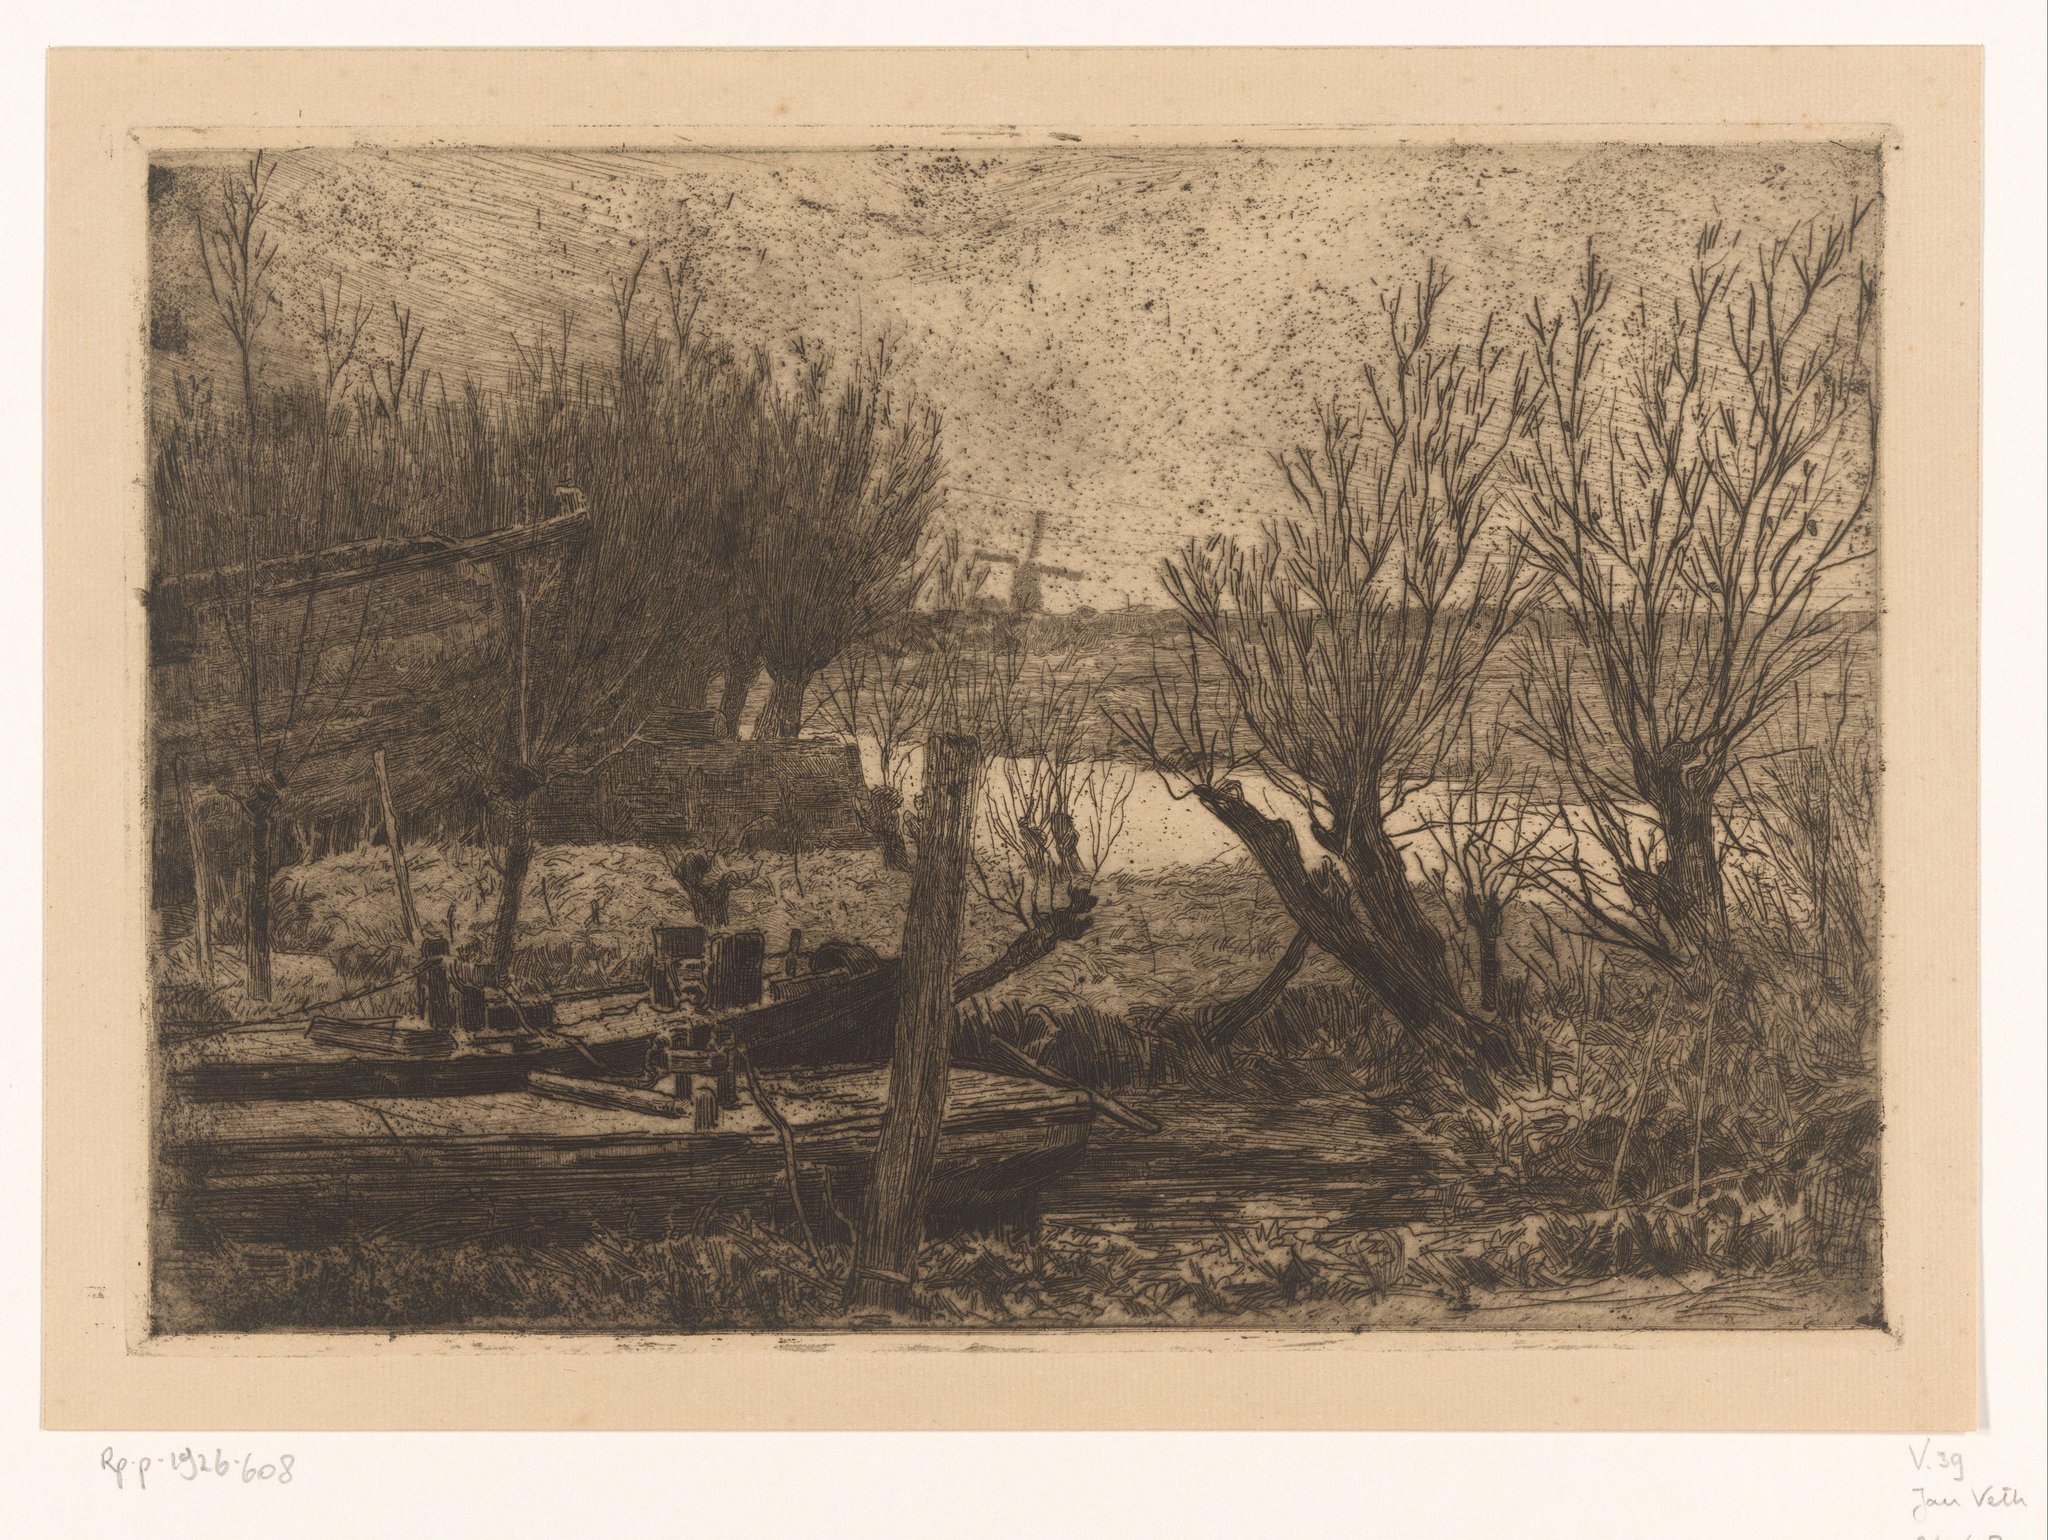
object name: print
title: Landschap met schuiten in een sloot nabij een vaart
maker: jan veth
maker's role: designer, draughtsman, painter, print maker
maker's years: 1864-1925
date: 1889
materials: paper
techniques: etching, intaglio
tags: canal, ships, boats on land, beached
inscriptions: collector's mark: Lugt 2228